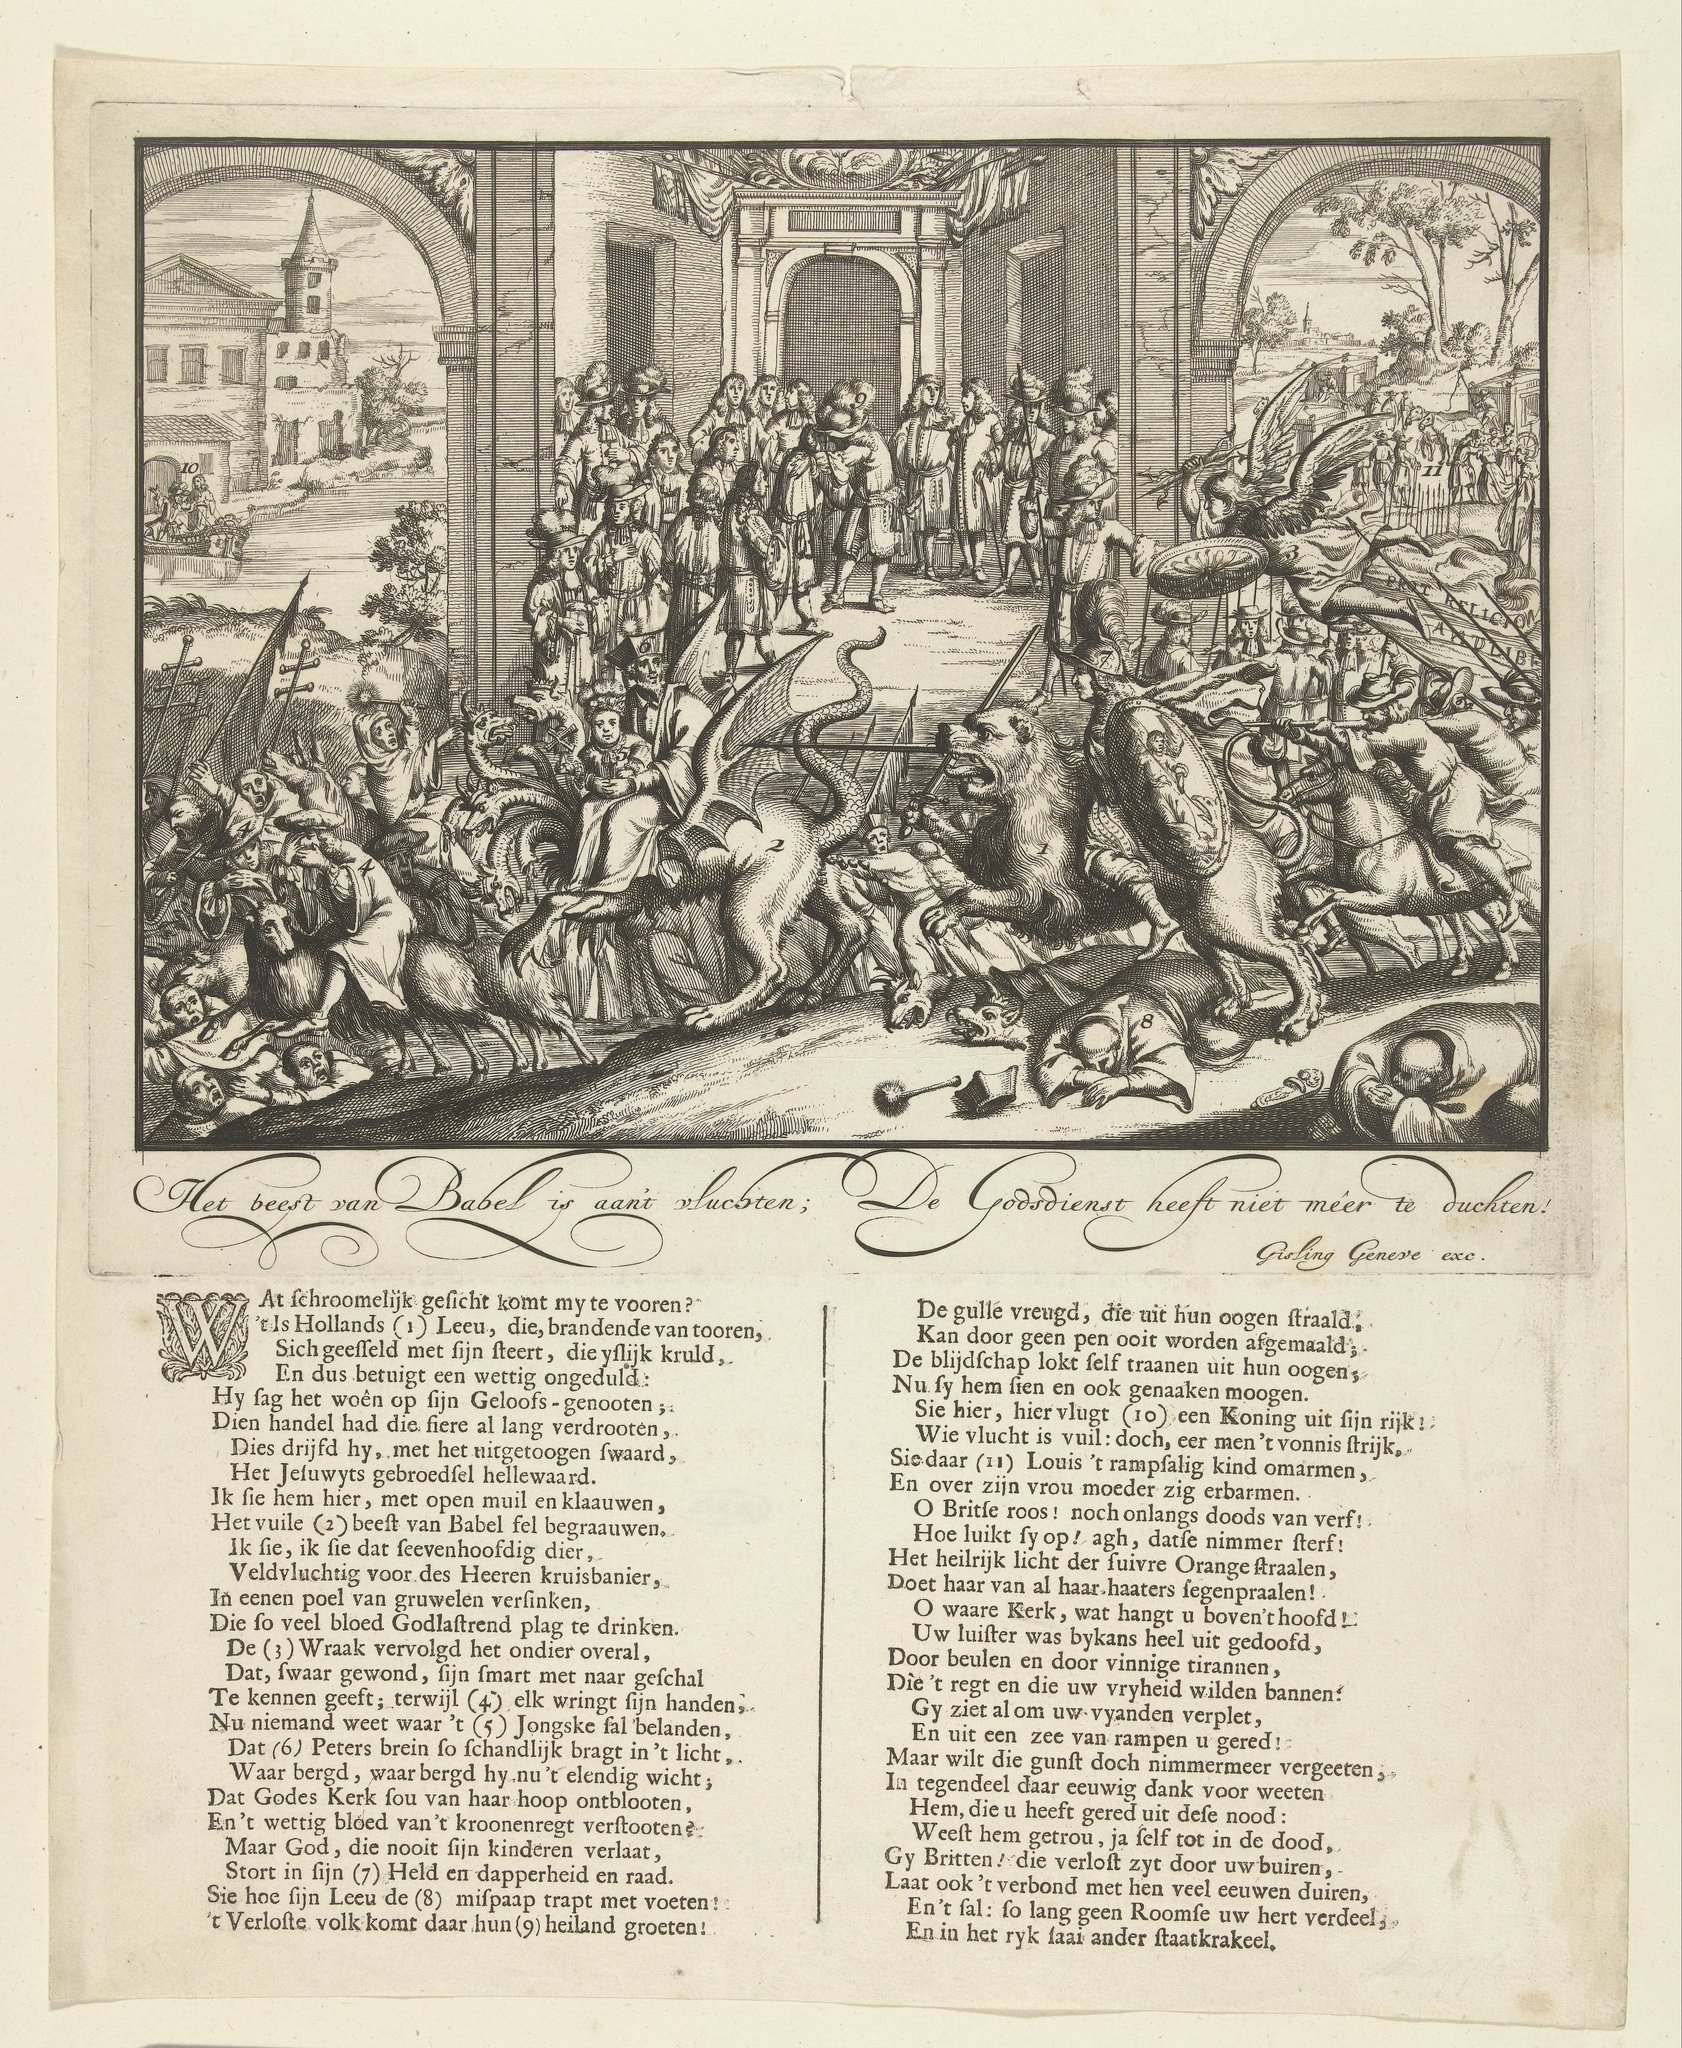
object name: cartoon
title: Het beest van Babel is aan't vluchten; De Godsdienst heeft niet meer te duchten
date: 1689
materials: paper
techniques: etching, letterpress printing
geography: northern netherlands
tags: jacobus ii (koning van engeland en schotland), the hague, william iii (prince of orange and king of england, scotland, and ireland), lodewijk xiv (koning van frankrijk), london, rome, the scarlet woman, the whore of babylon; she is usually sitting on a scarlet beast with seven heads and ten horns, political caricatures and satires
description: Prins Willem III als held op de Hollandse Leeuw verjaagt pater Peters met het molenaarskind zittend als de hoer van Babylon op het beest samen met alle andere katholieken, 1689. Midden achter wordt Willem verwelkomd door de Engelsen, op de achtergrond links en rechts het vluchten van koning Jacobus II uit Londen en zijn aankomst in Frankrijk bij Lodewijk XIV. Op het blad onder de plaat een vers in twee kolommen.